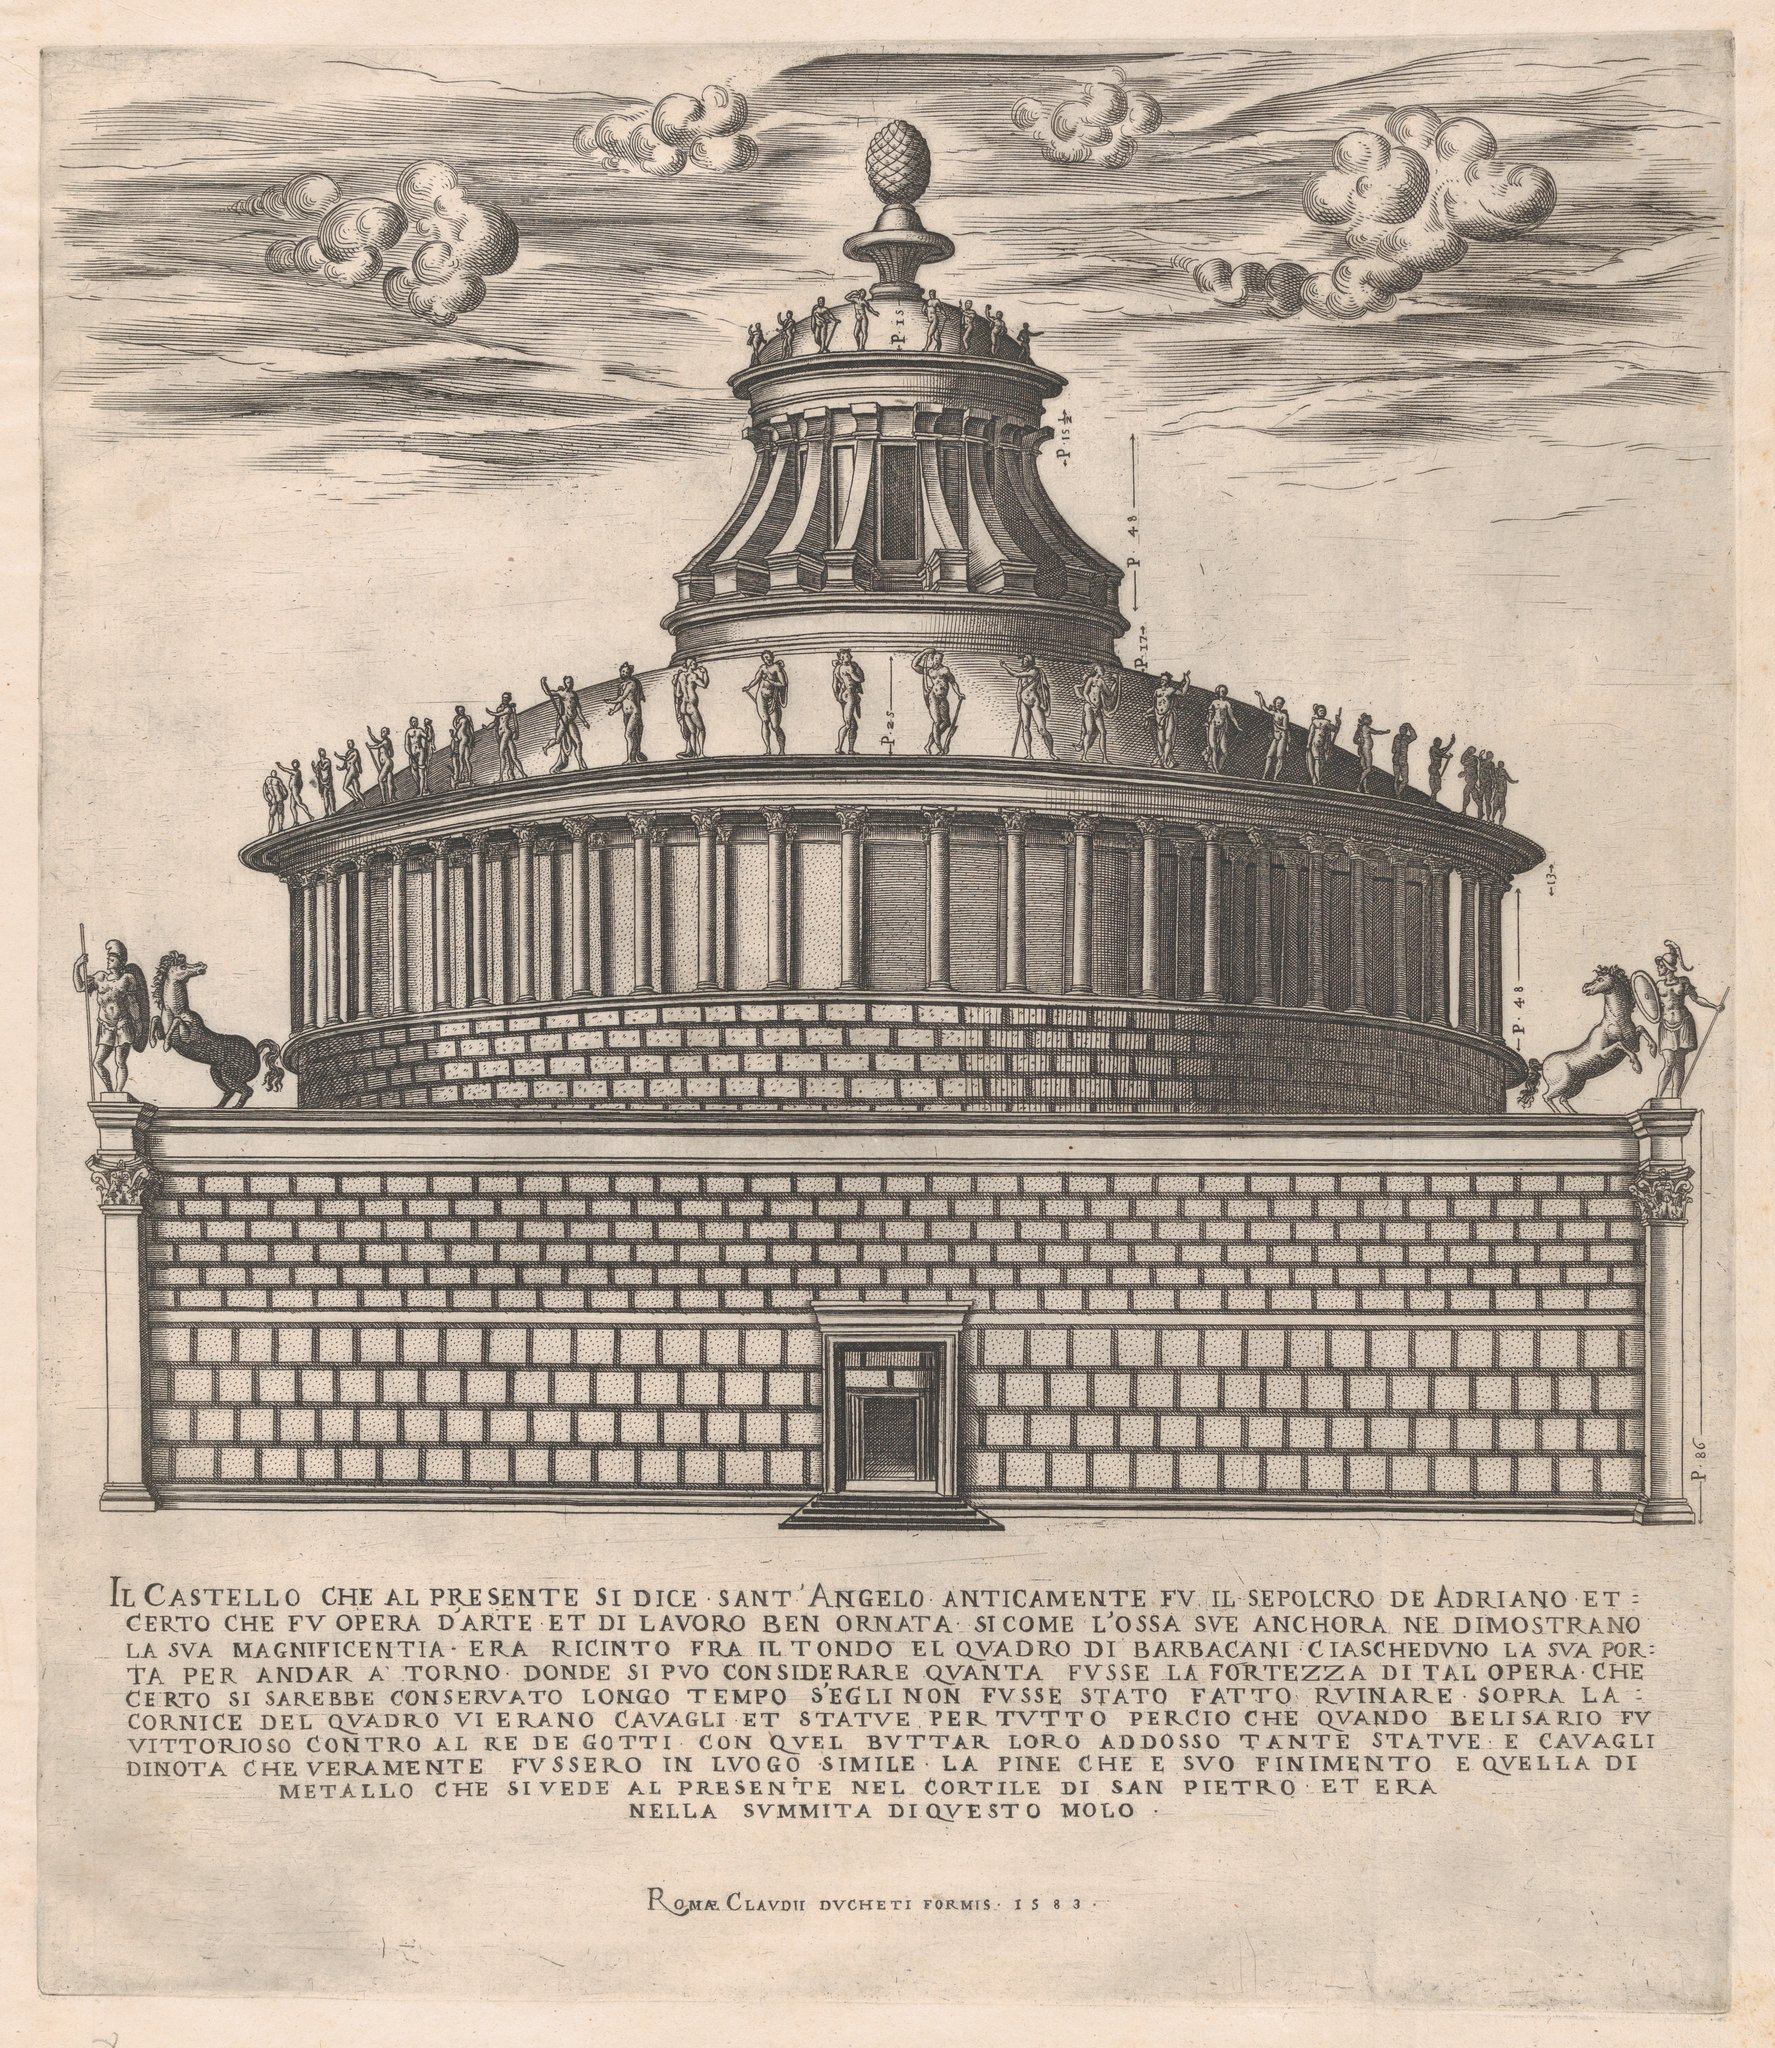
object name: print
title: The Sepulchre of Hadrian, from "Speculum Romanae Magnificentiae"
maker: Anonymous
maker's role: artist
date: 1583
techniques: engraving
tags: human figures,sculpture,architecture,horses,rome